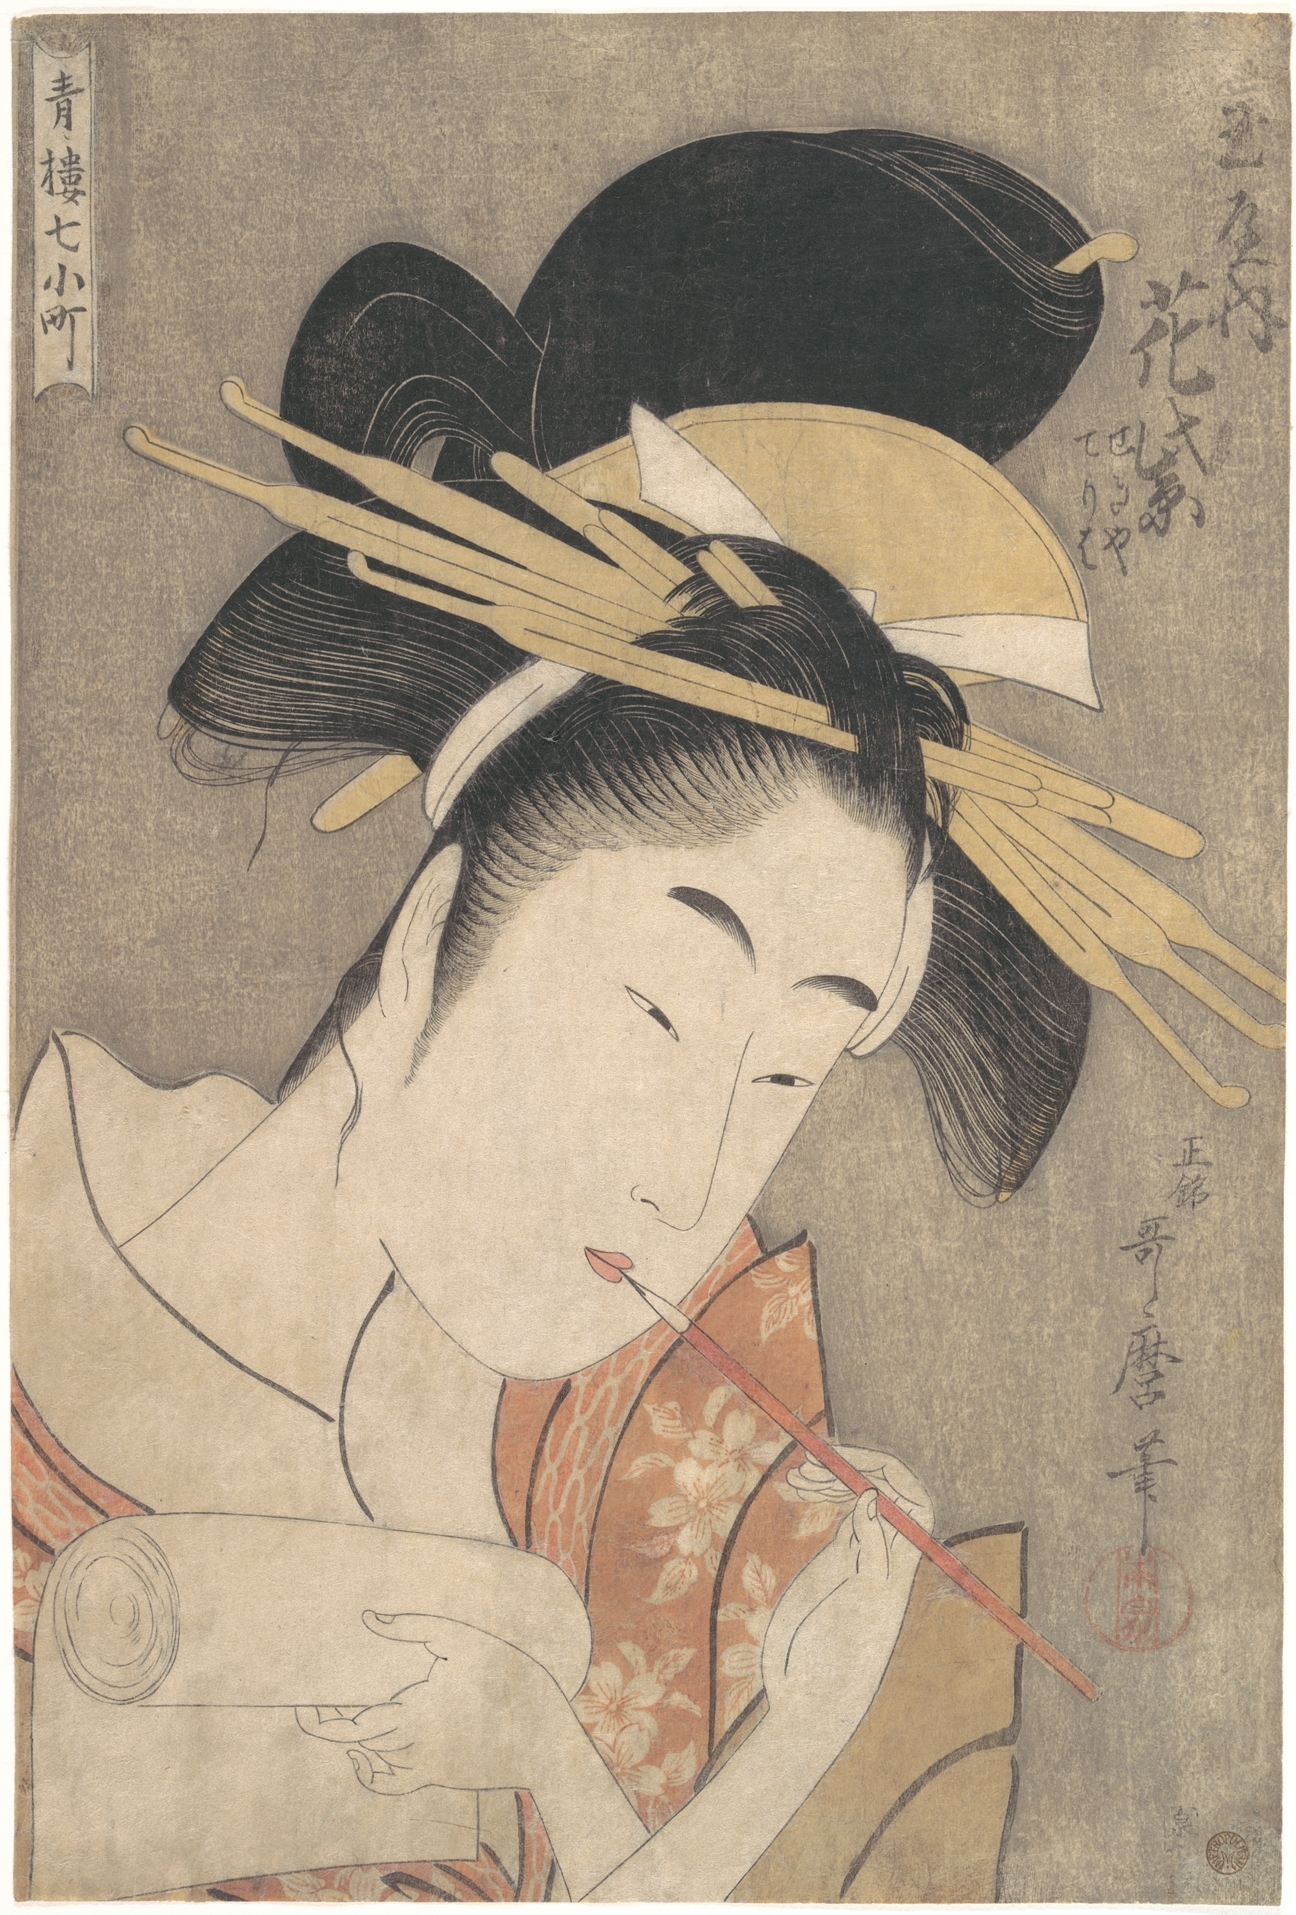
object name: print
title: “Hanamurasaki of the Tamaya,” from the series Seven Komachi of the Pleasure Quarters (Seirō Nana Komachi)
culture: japanese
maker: kitagawa utamaro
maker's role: artist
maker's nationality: japanese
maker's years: 1754-1806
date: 1790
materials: ink, paper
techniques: woodblock print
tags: women,writing